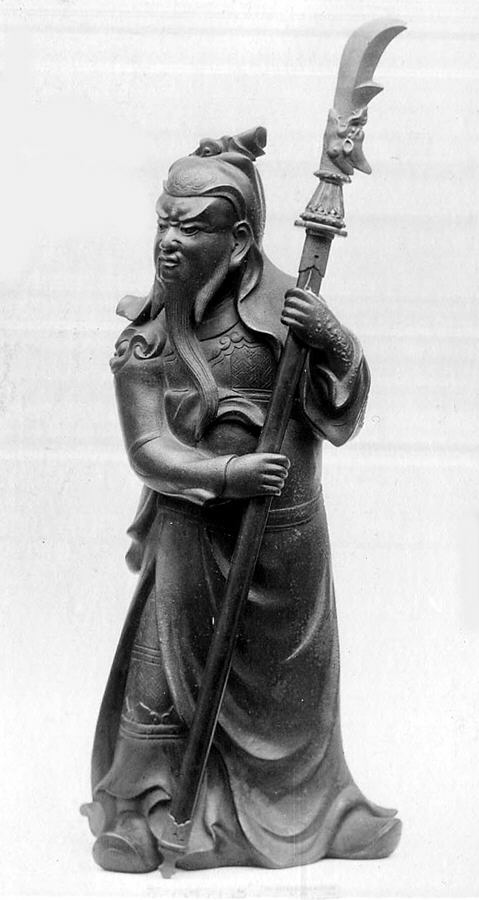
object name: figure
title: Chinese General (Guanu)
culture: japanese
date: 1800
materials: glaze, stoneware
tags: weapons,men,generals